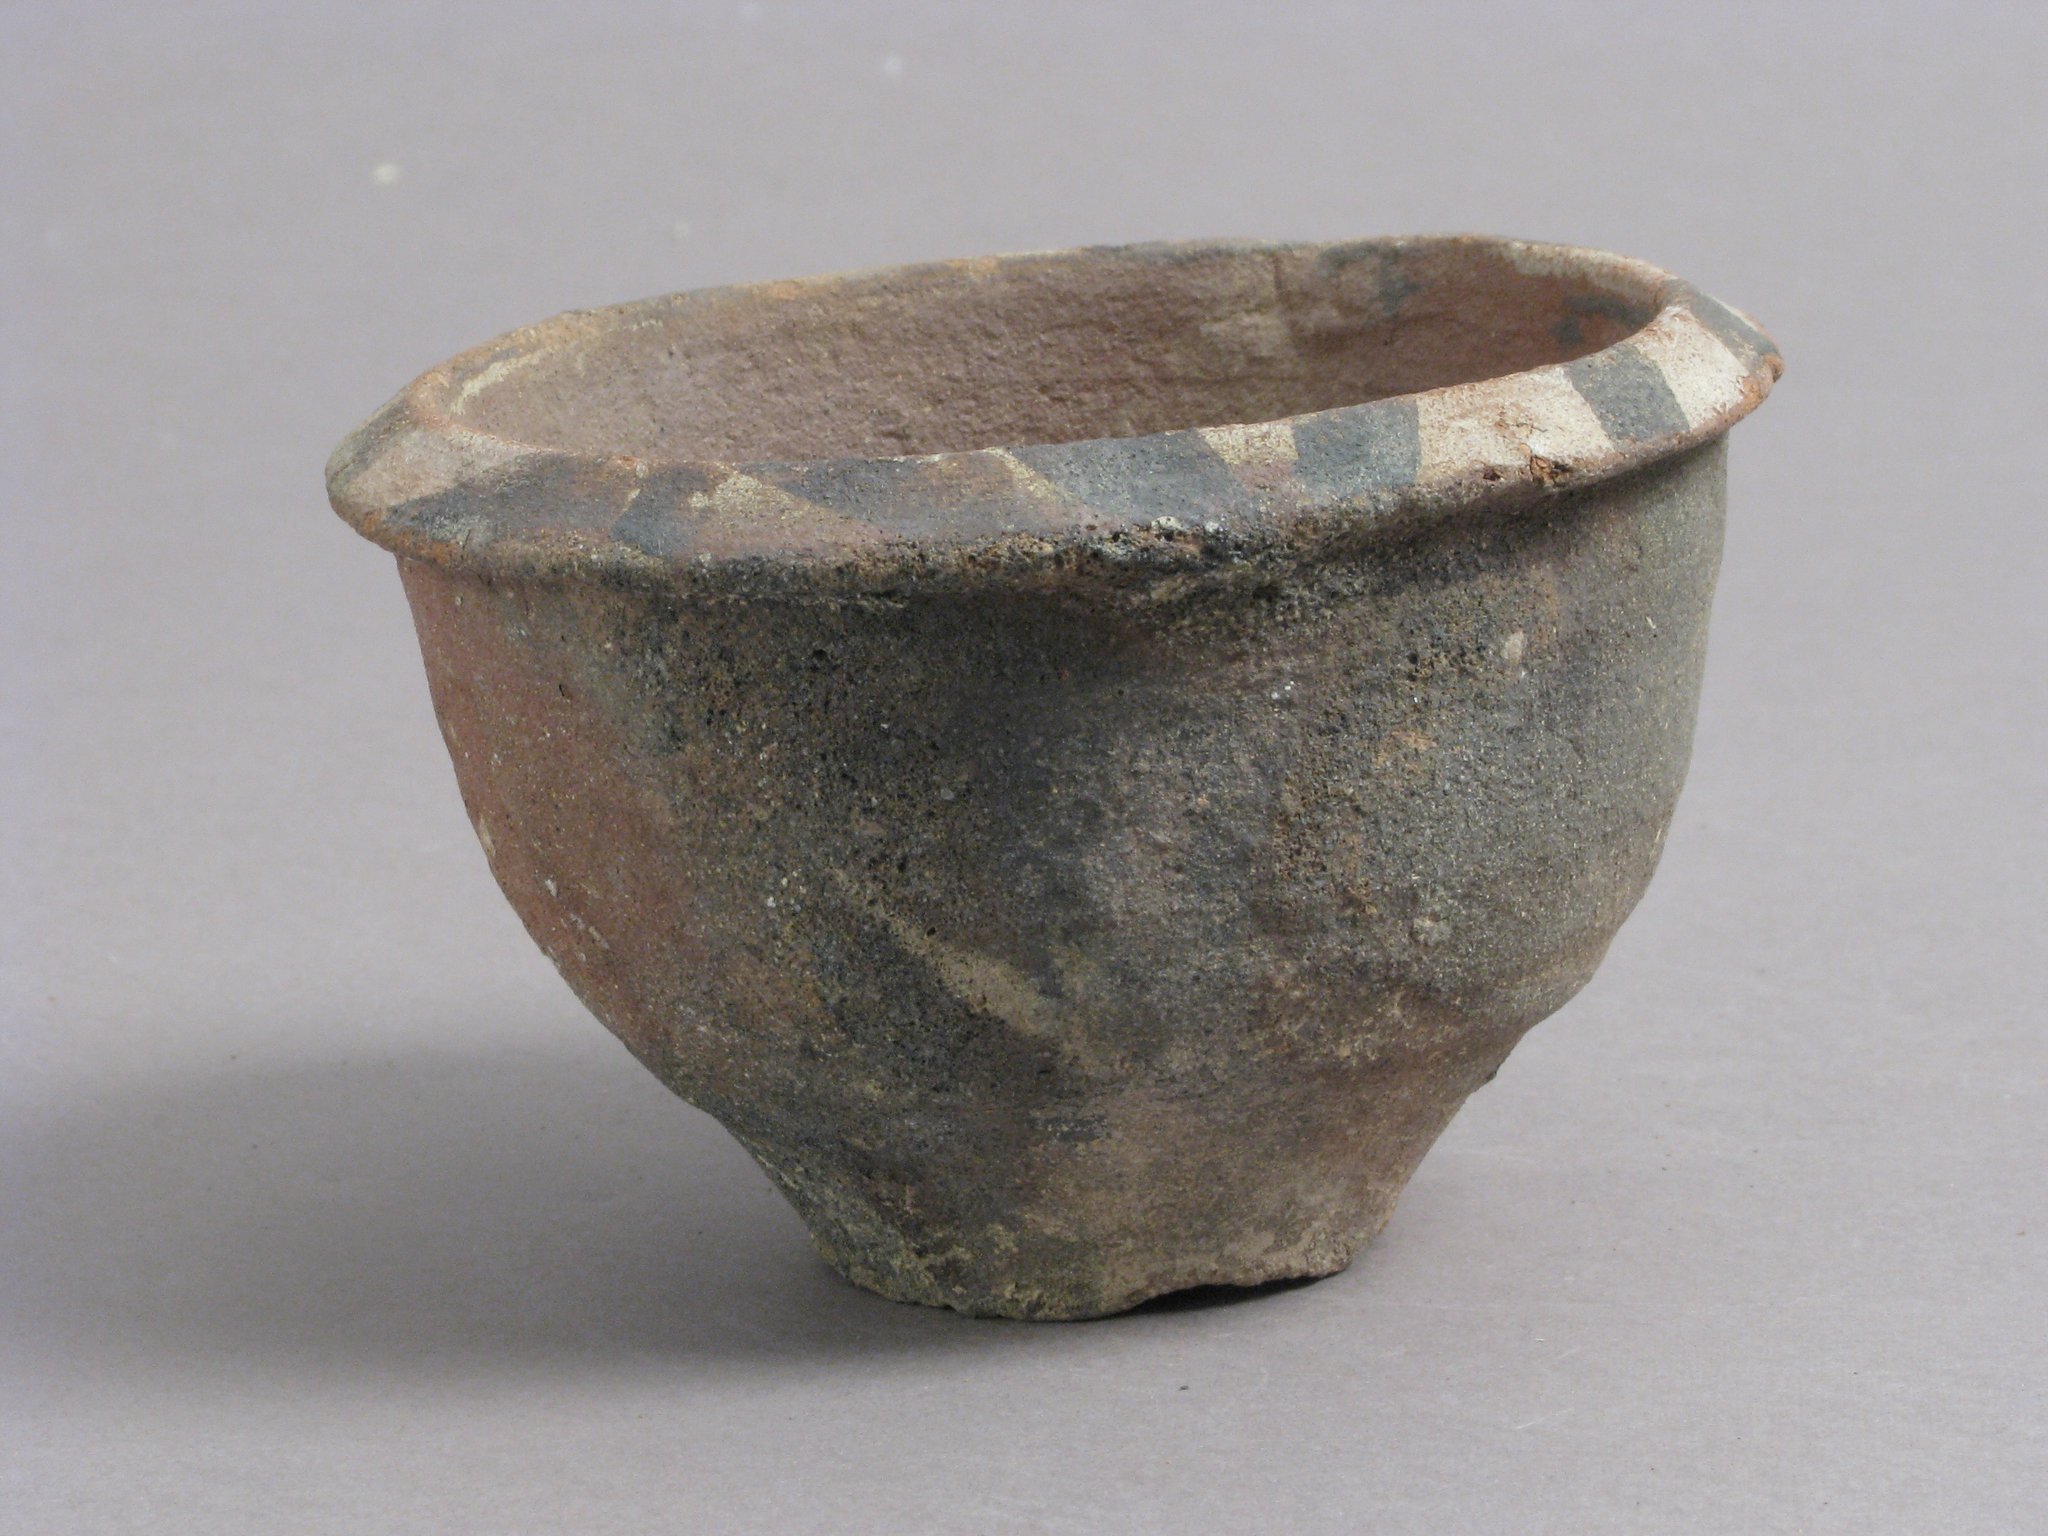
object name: bowl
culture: coptic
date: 301-700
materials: earthenware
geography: egypt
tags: bowls